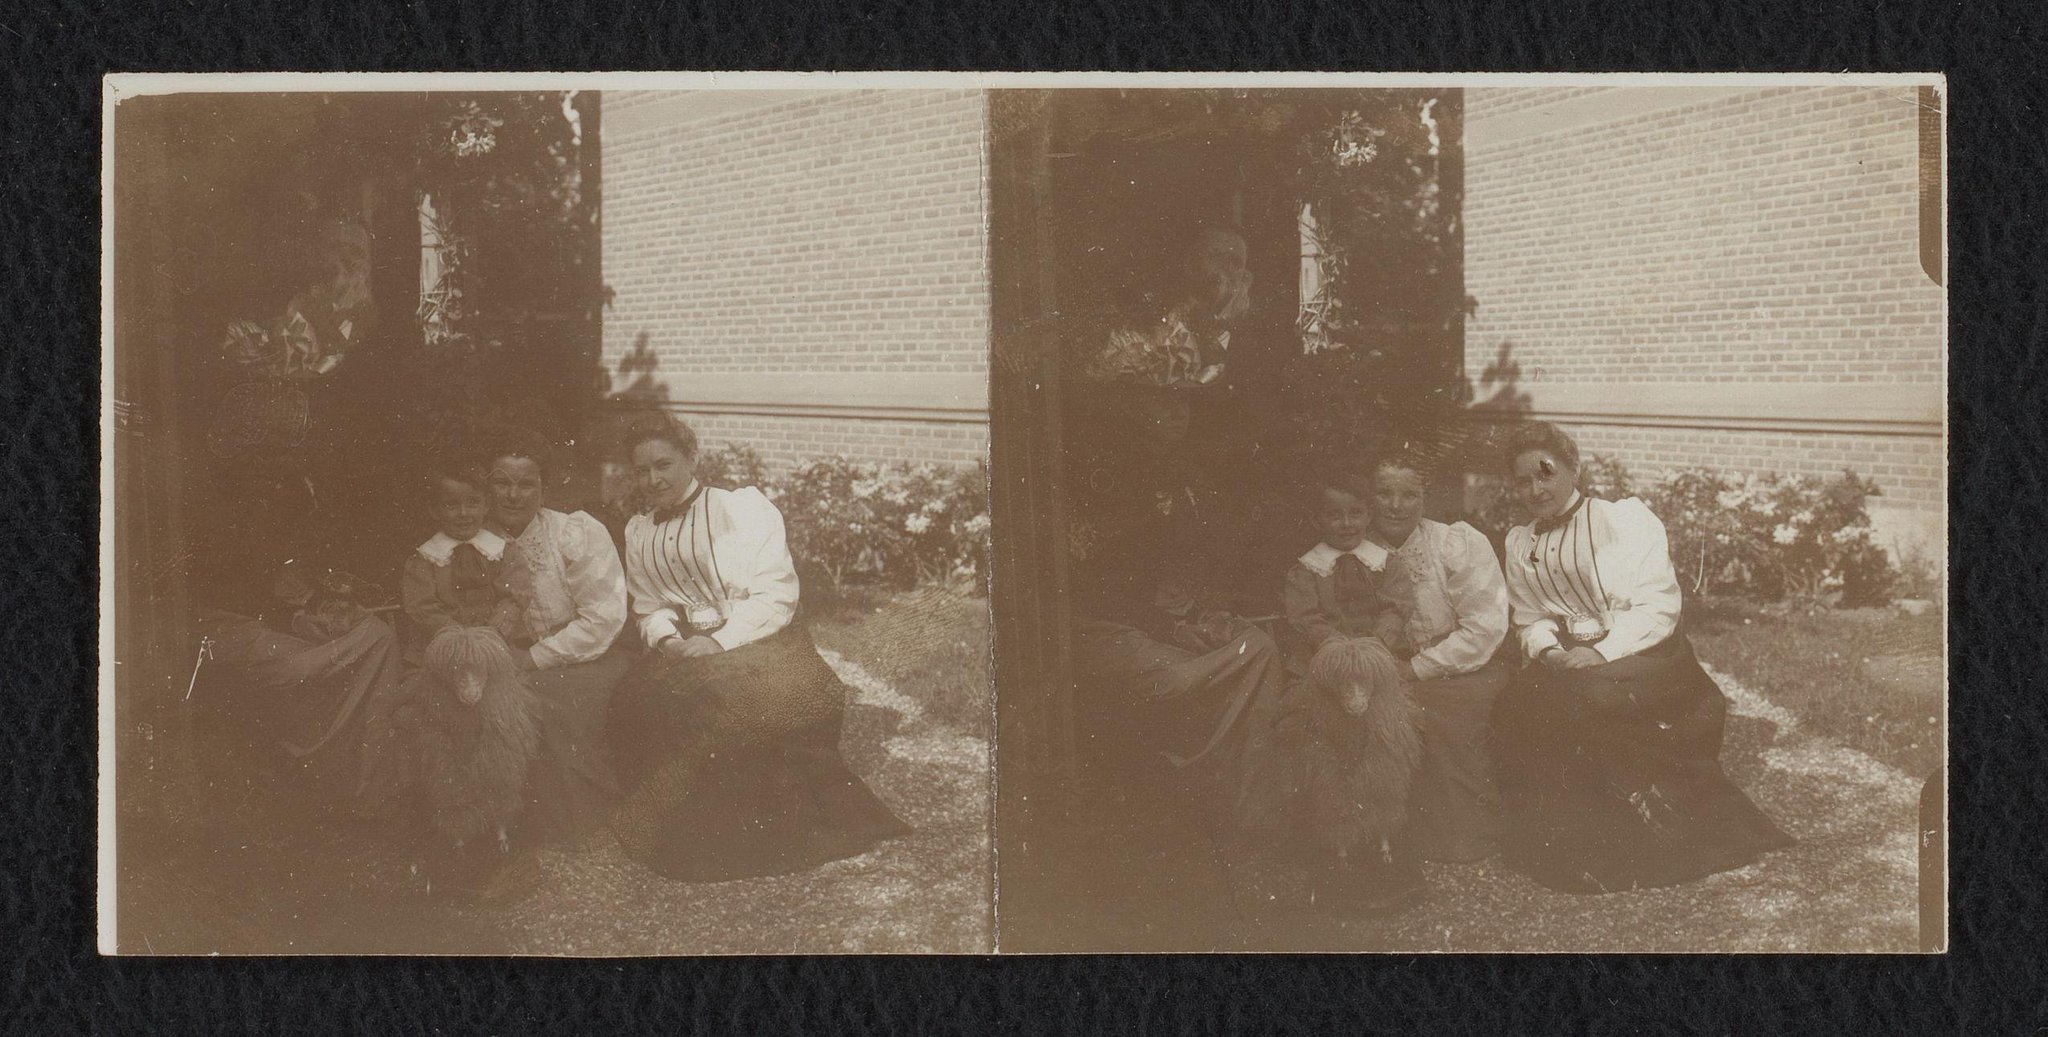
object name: stereograph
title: Margo Kessler met Boelie en twee onbekende vrouwen in een tuin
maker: jean baptiste august kessler (1853-1900)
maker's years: 1853-1900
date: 1898-1900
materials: paper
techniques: collodion silver print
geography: netherlands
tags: margaretha jacoba johanna kessler-de lange (margo), the hague, hermann johannes kessler (boelie), mother and son(s) (family group), garden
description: Uit envelop van Hendrik A. Matthes (1861 – 1919; Keizersgracht 756, Amsterdam), met opschrift van een van de kinderen van August Kessler (1853-1900): 'Photo's die Papaatje bij zich had.'